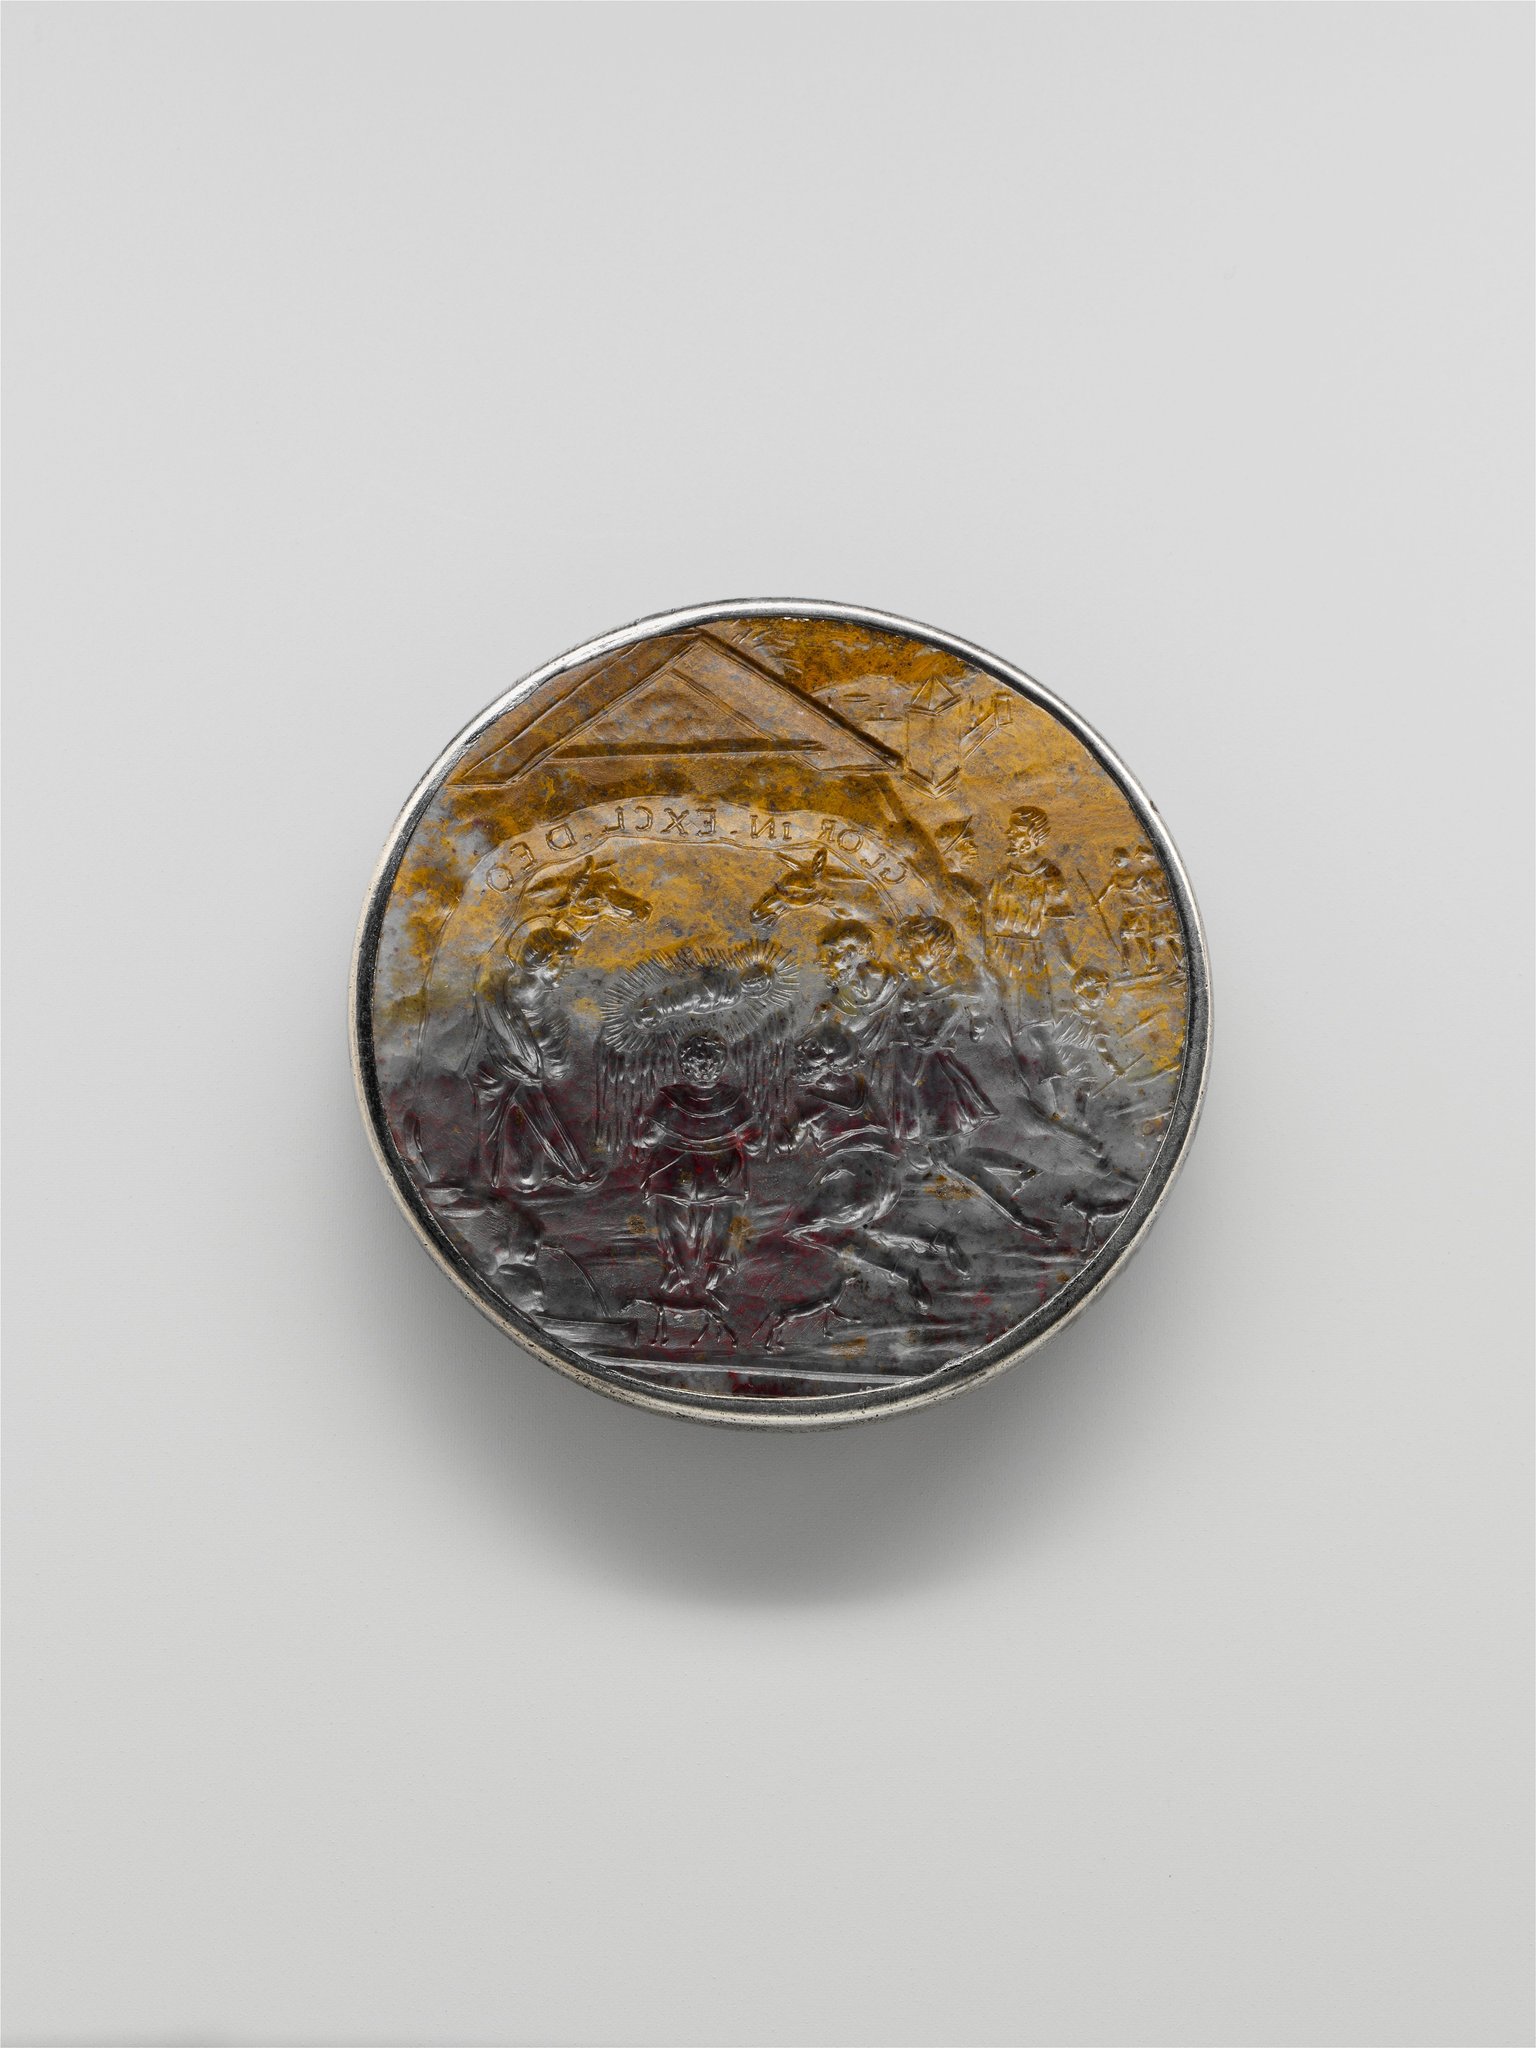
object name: intaglio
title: Adoration of the Shepherds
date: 1500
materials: jasper, silver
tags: shepherds